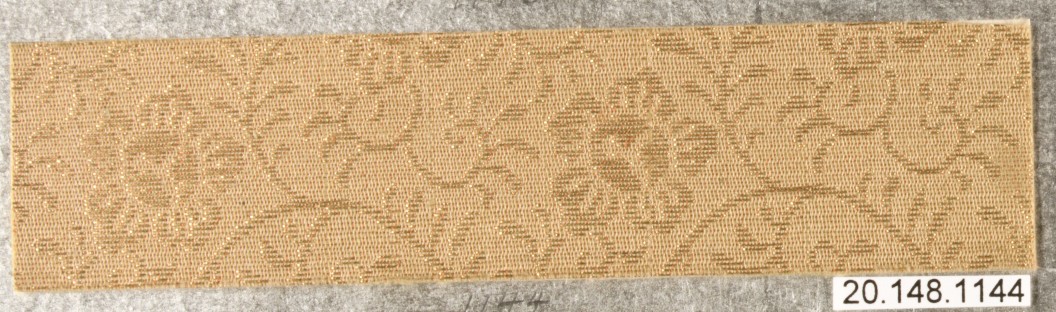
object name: piece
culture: japanese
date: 1801-1900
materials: silk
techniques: compound weave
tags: flowers,leaves